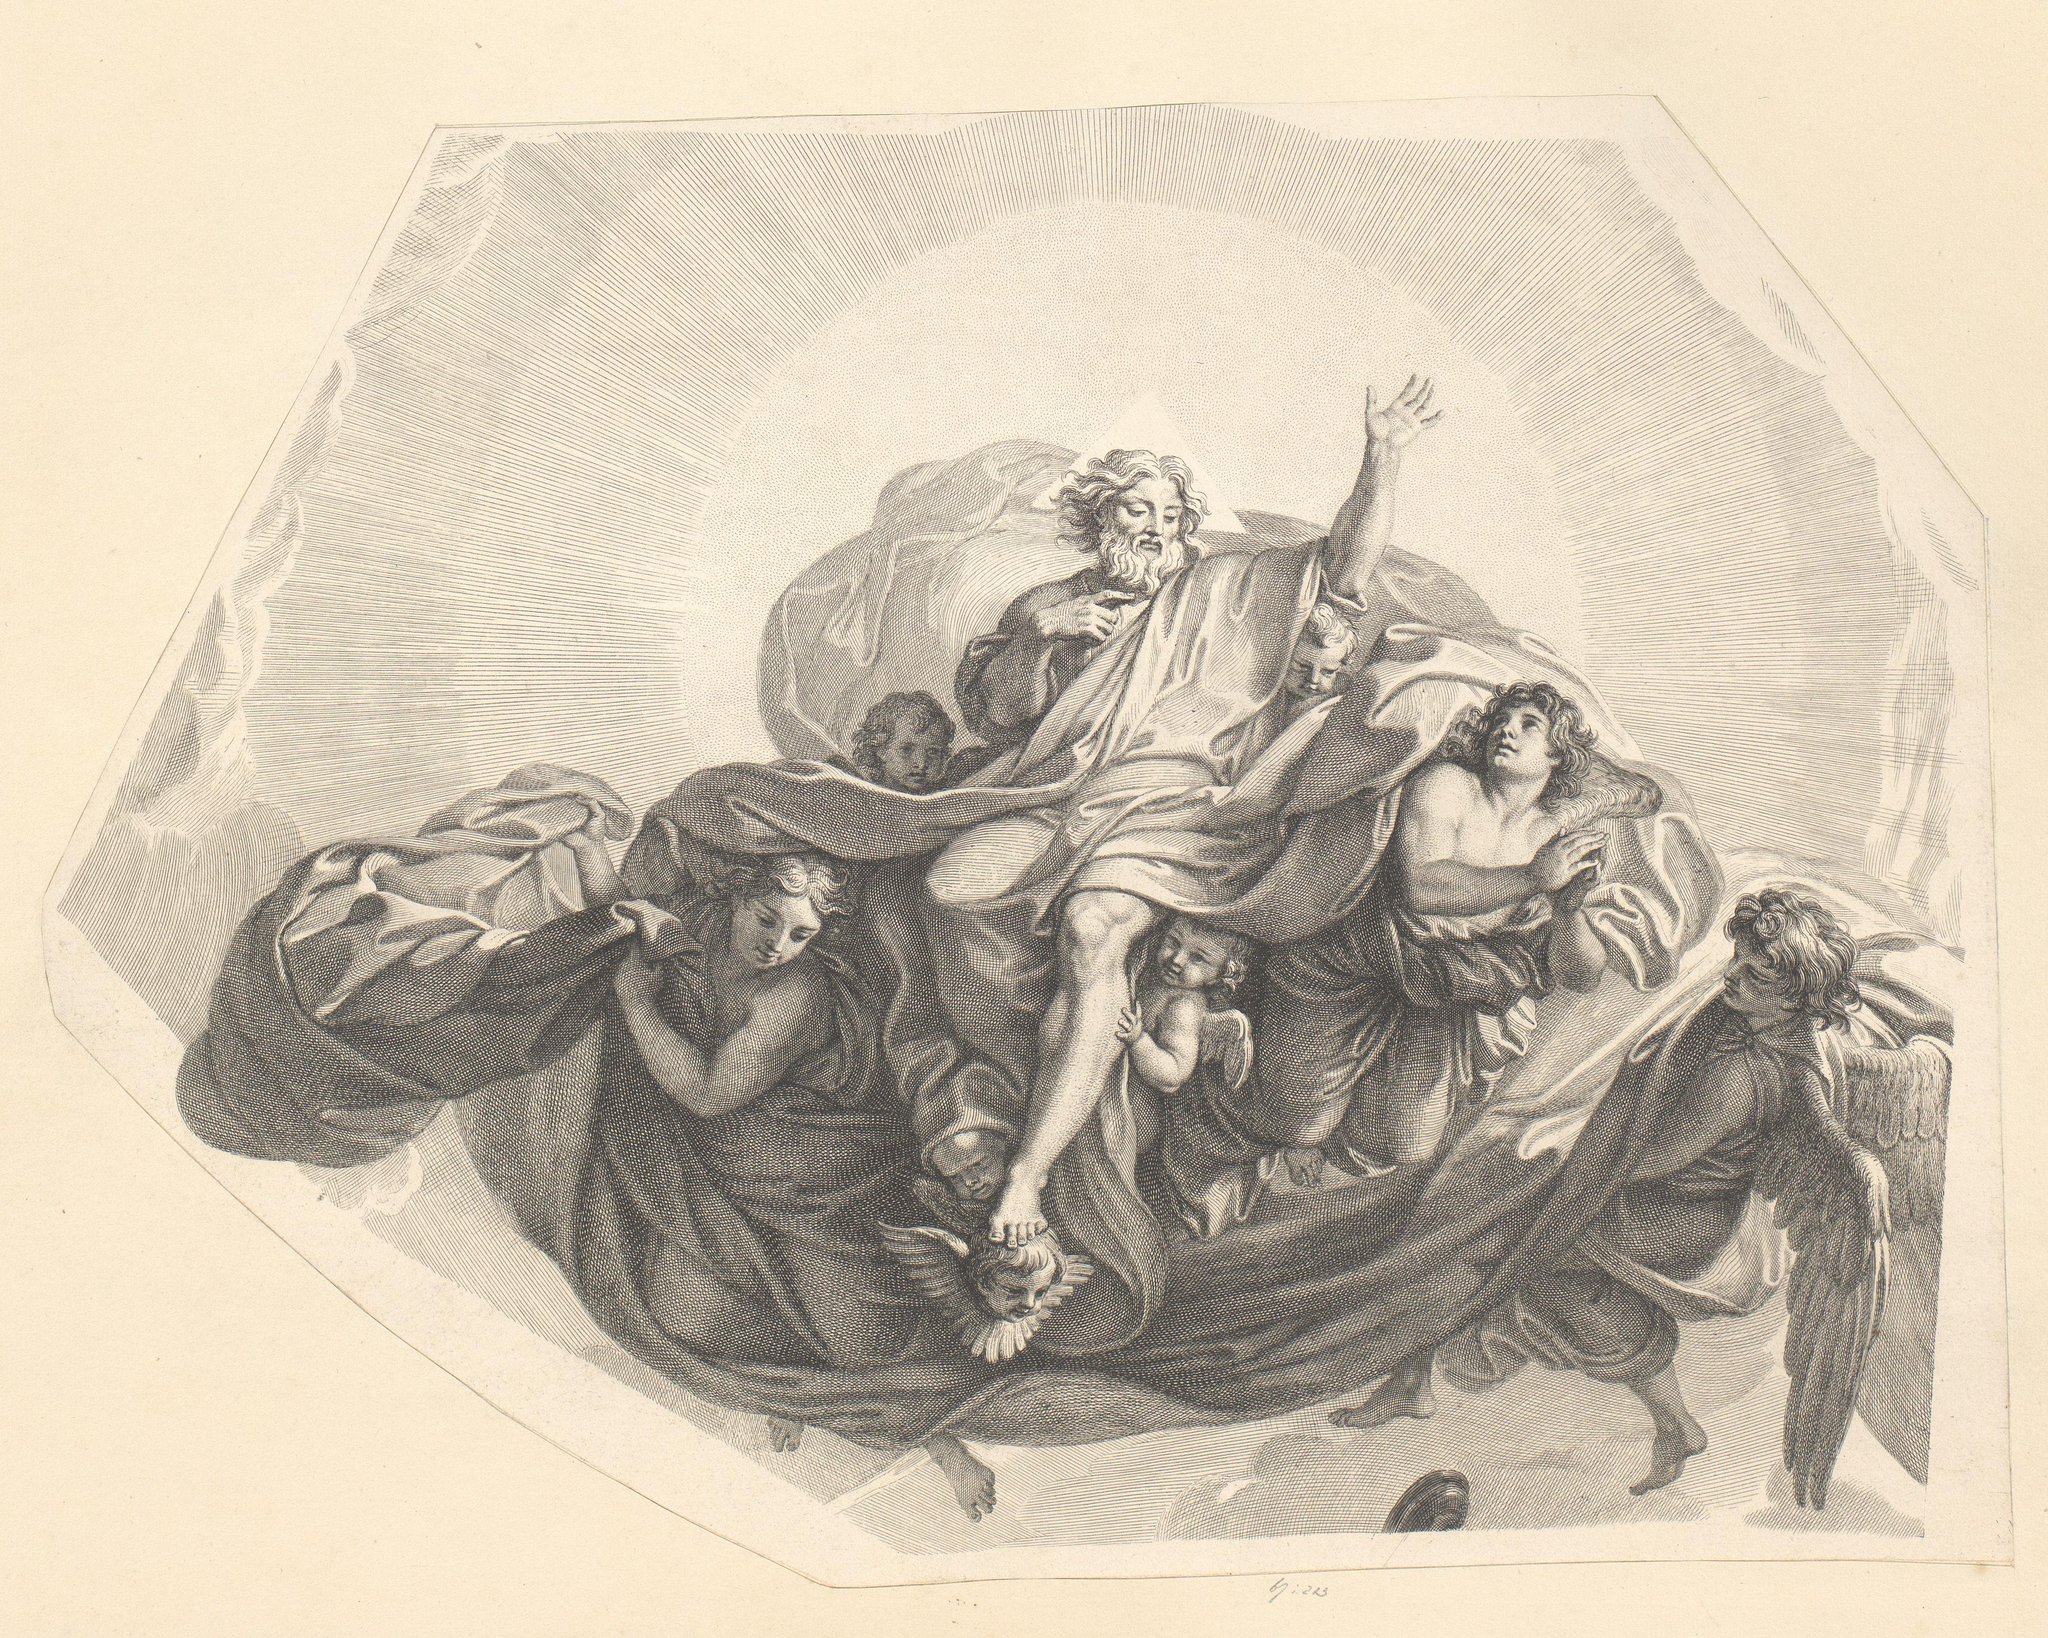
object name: album leaf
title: God omringd en gedragen door engelen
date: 1681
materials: paper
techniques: engraving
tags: god the father, angels in adoration, (decorated) ceiling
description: Centrale van vijf prenten die samen het plafond van de kapel van Sceaux vormen. Deze prent maakt deel uit van een album.